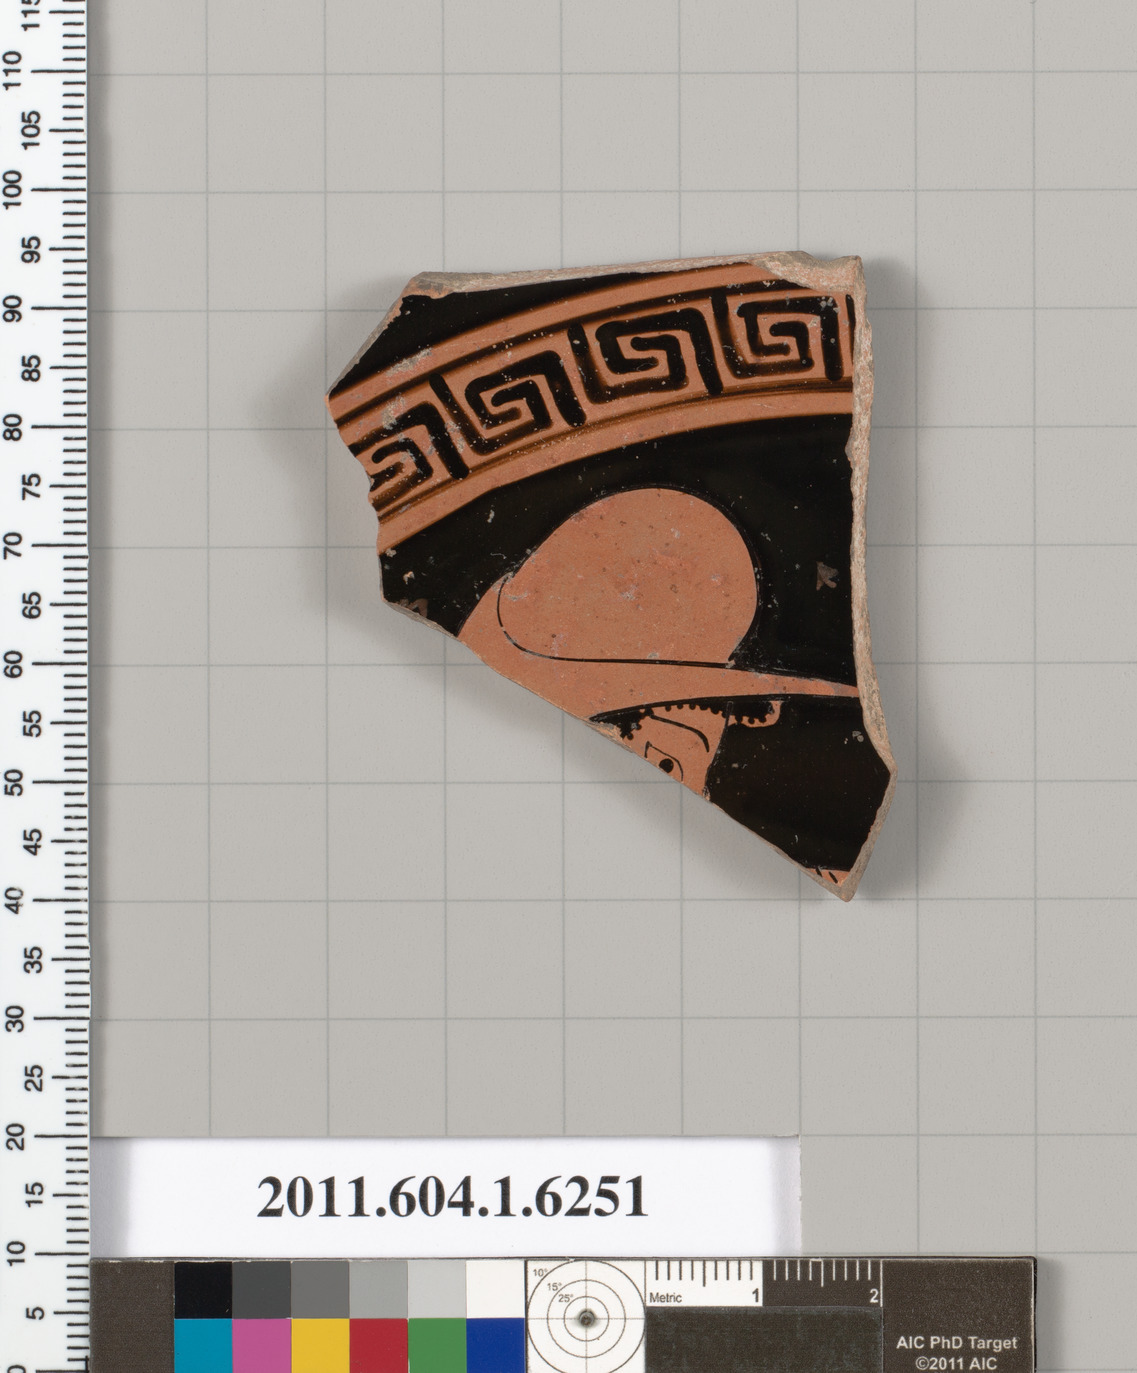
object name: kylix fragment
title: Terracotta fragment of a kylix (drinking cup)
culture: greek, attic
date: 500-480 BCE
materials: terracotta